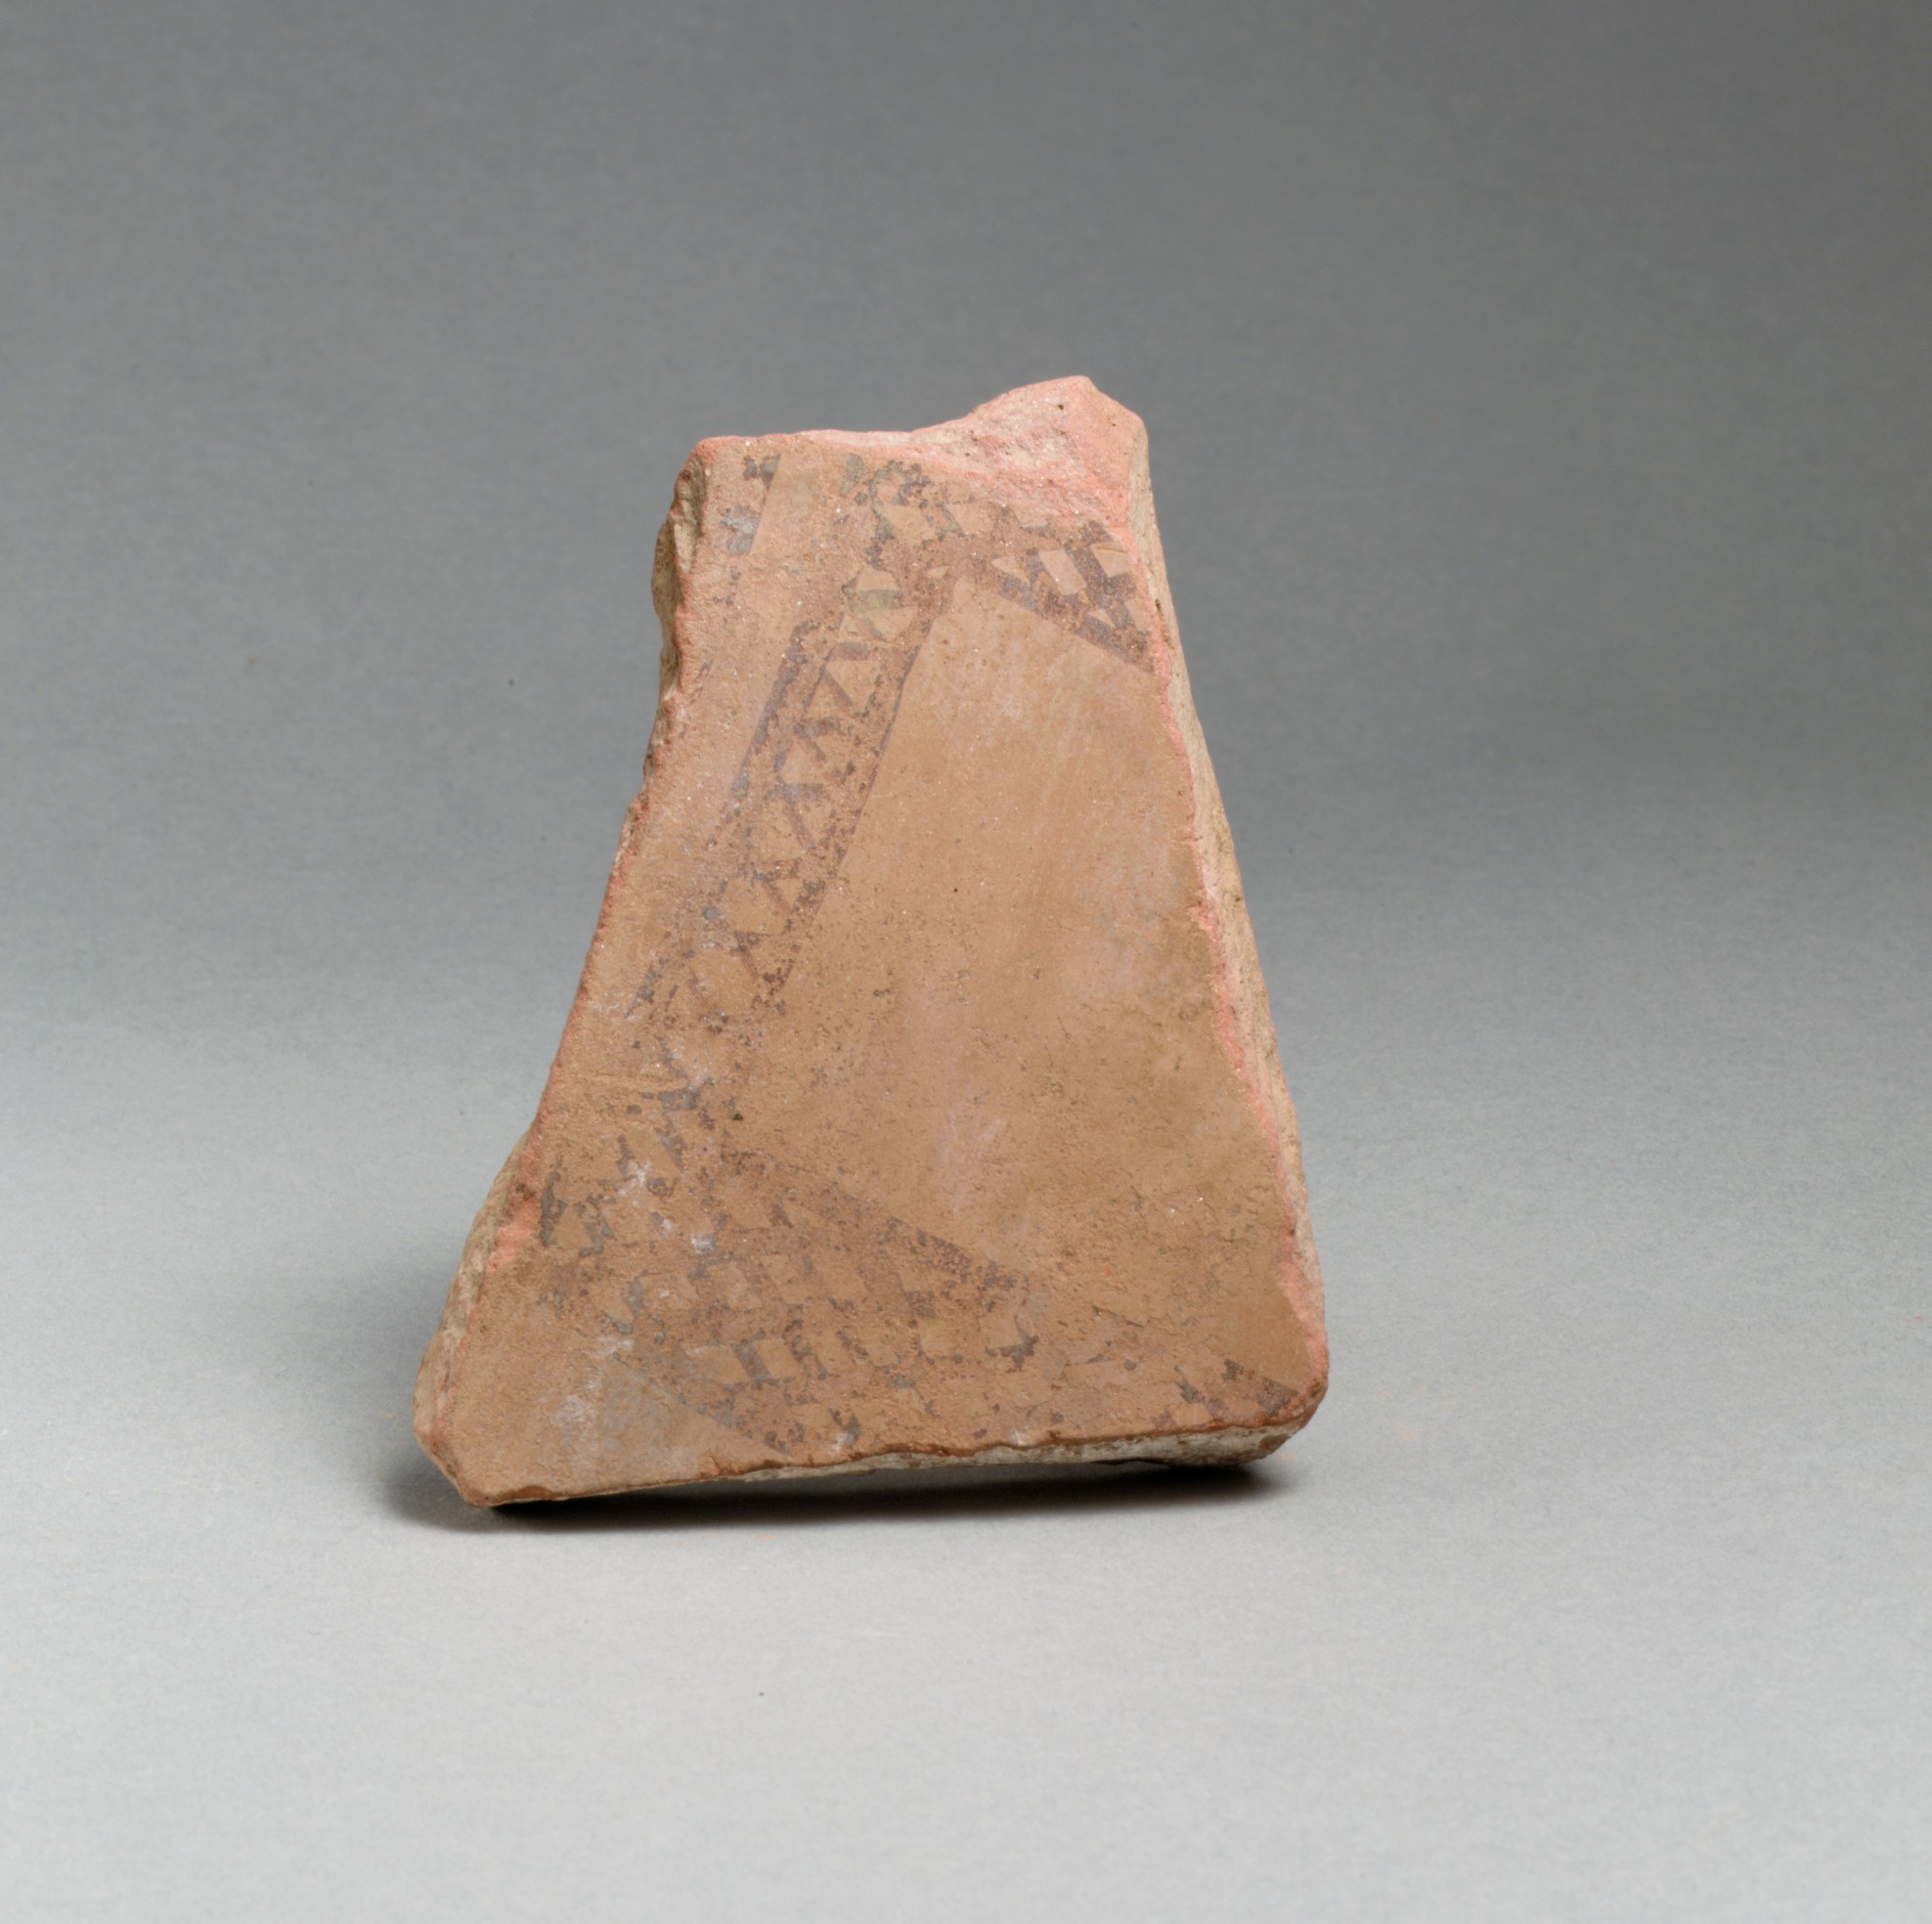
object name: vase fragment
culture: greek or lydian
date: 1050-700 BCE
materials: terracotta